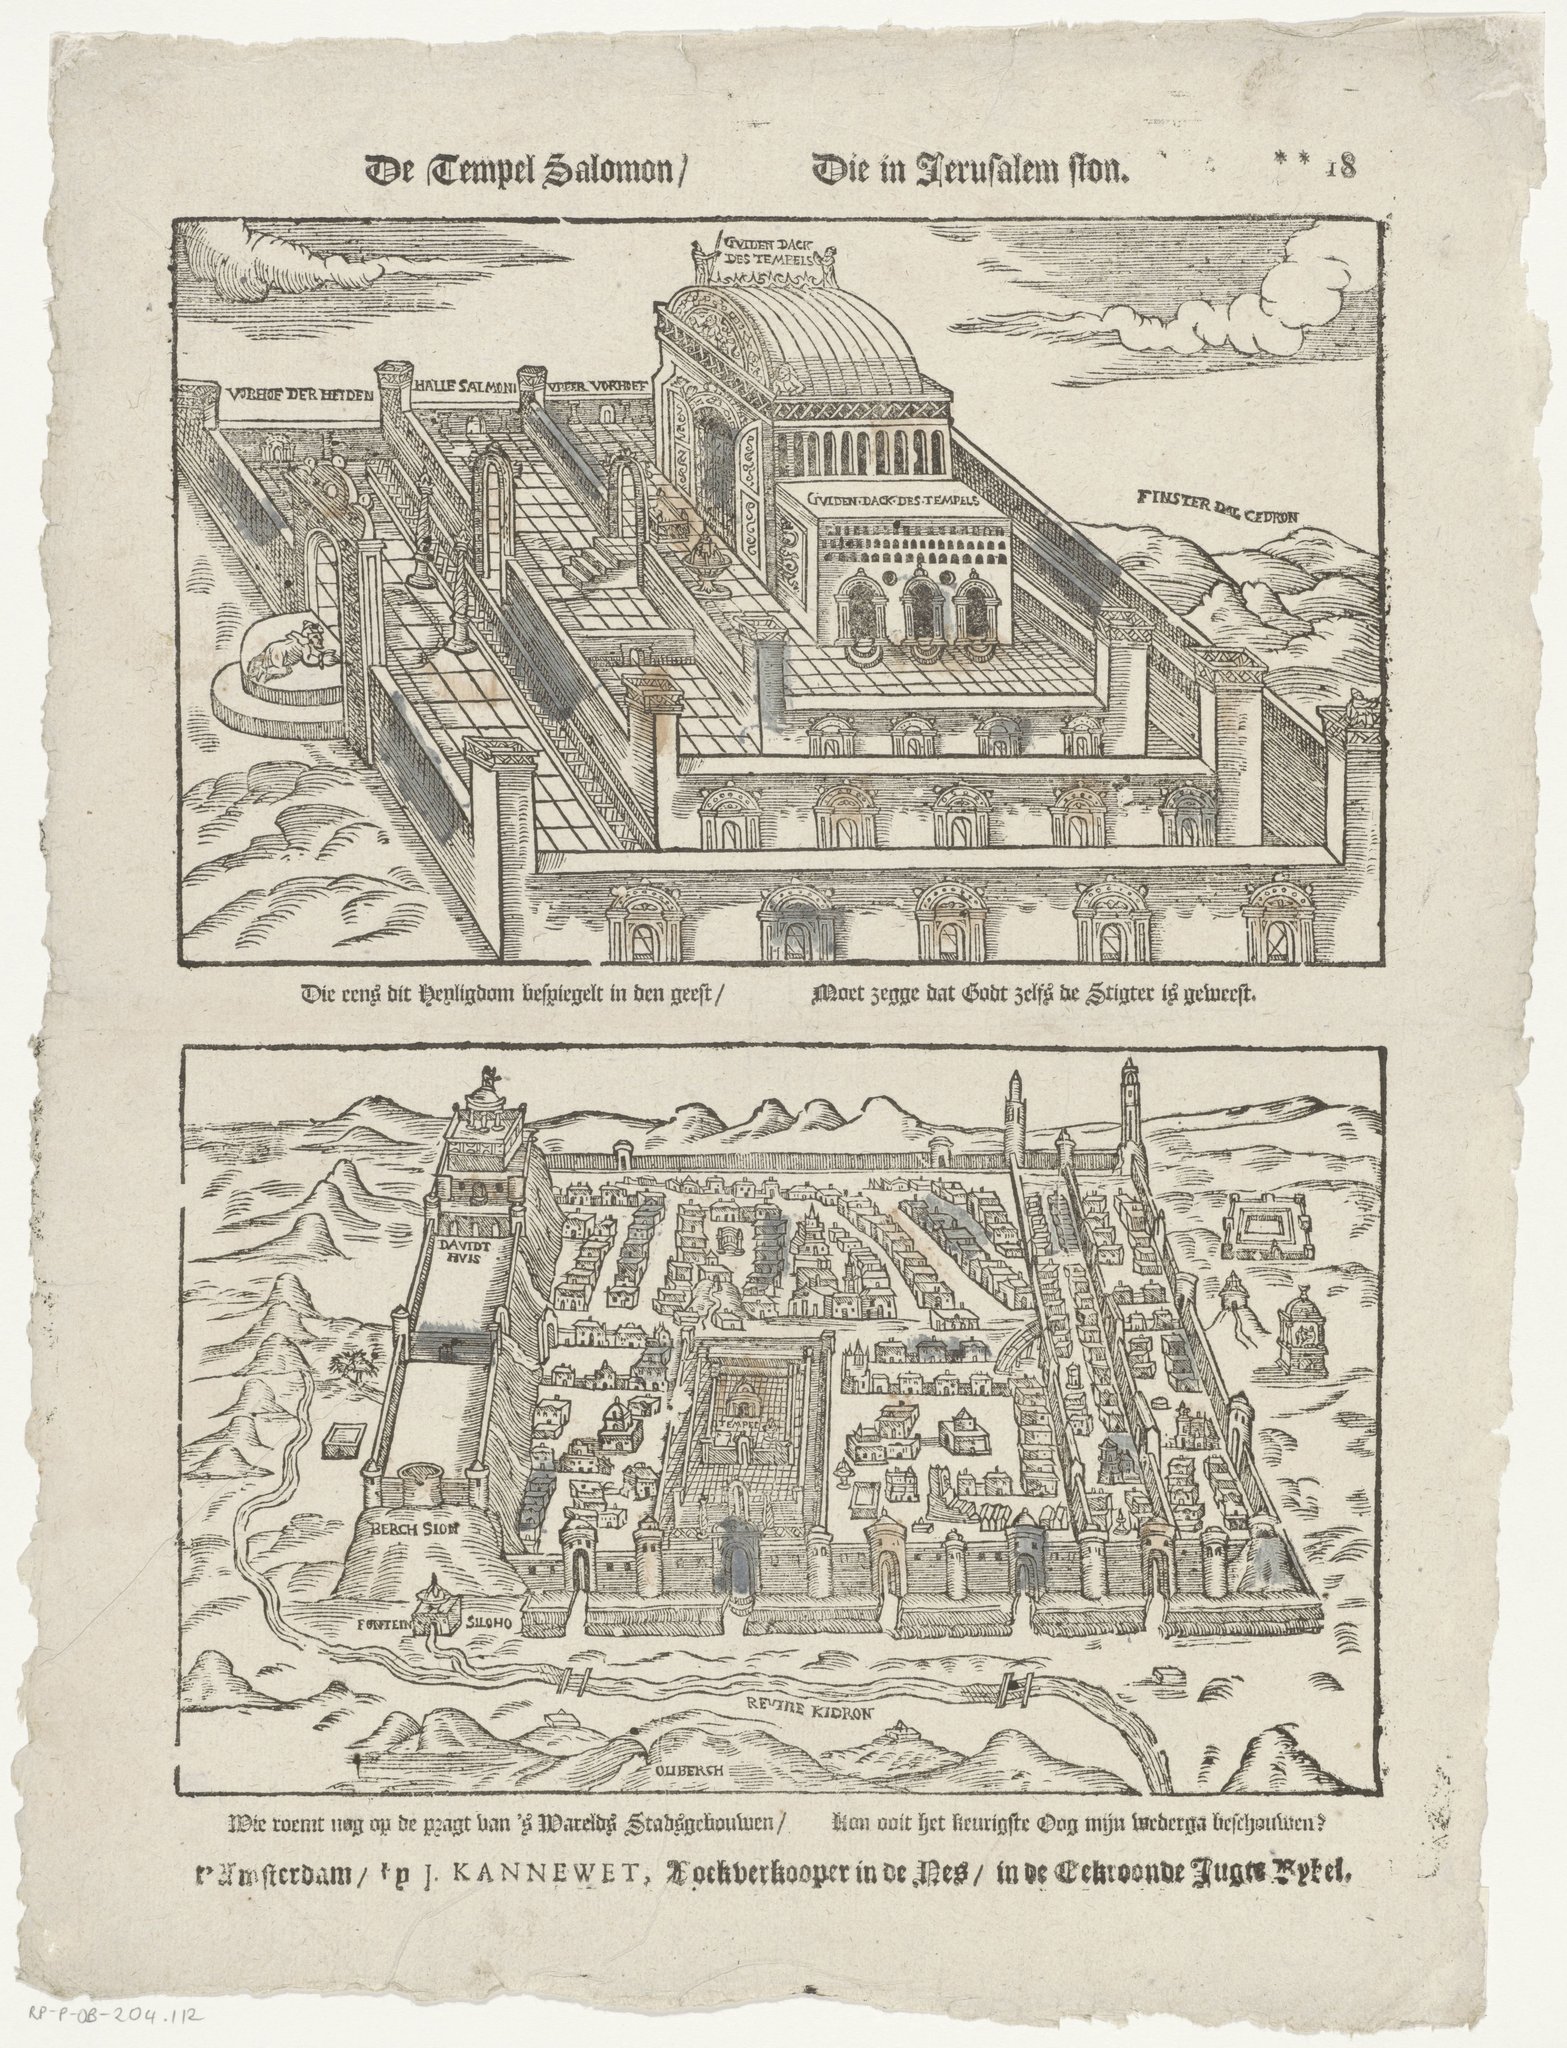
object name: print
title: De tempel Salomon / Die in Jerusalem ston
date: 1725-1780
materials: paper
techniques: colour, letterpress printing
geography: netherlands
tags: city-view, and landscape with man-made constructions, temple of solomon (1 kings 5-9; 2 chronicles 2-7)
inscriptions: collector's mark: Lugt 2760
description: Blad met 2 voorstellingen. Boven een voorstelling van de tempel van Salomo. Onder een zicht op de stad Jeruzalem. Onder elke afbeelding een tweeregelig vers. Genummerd rechtsboven: **18.